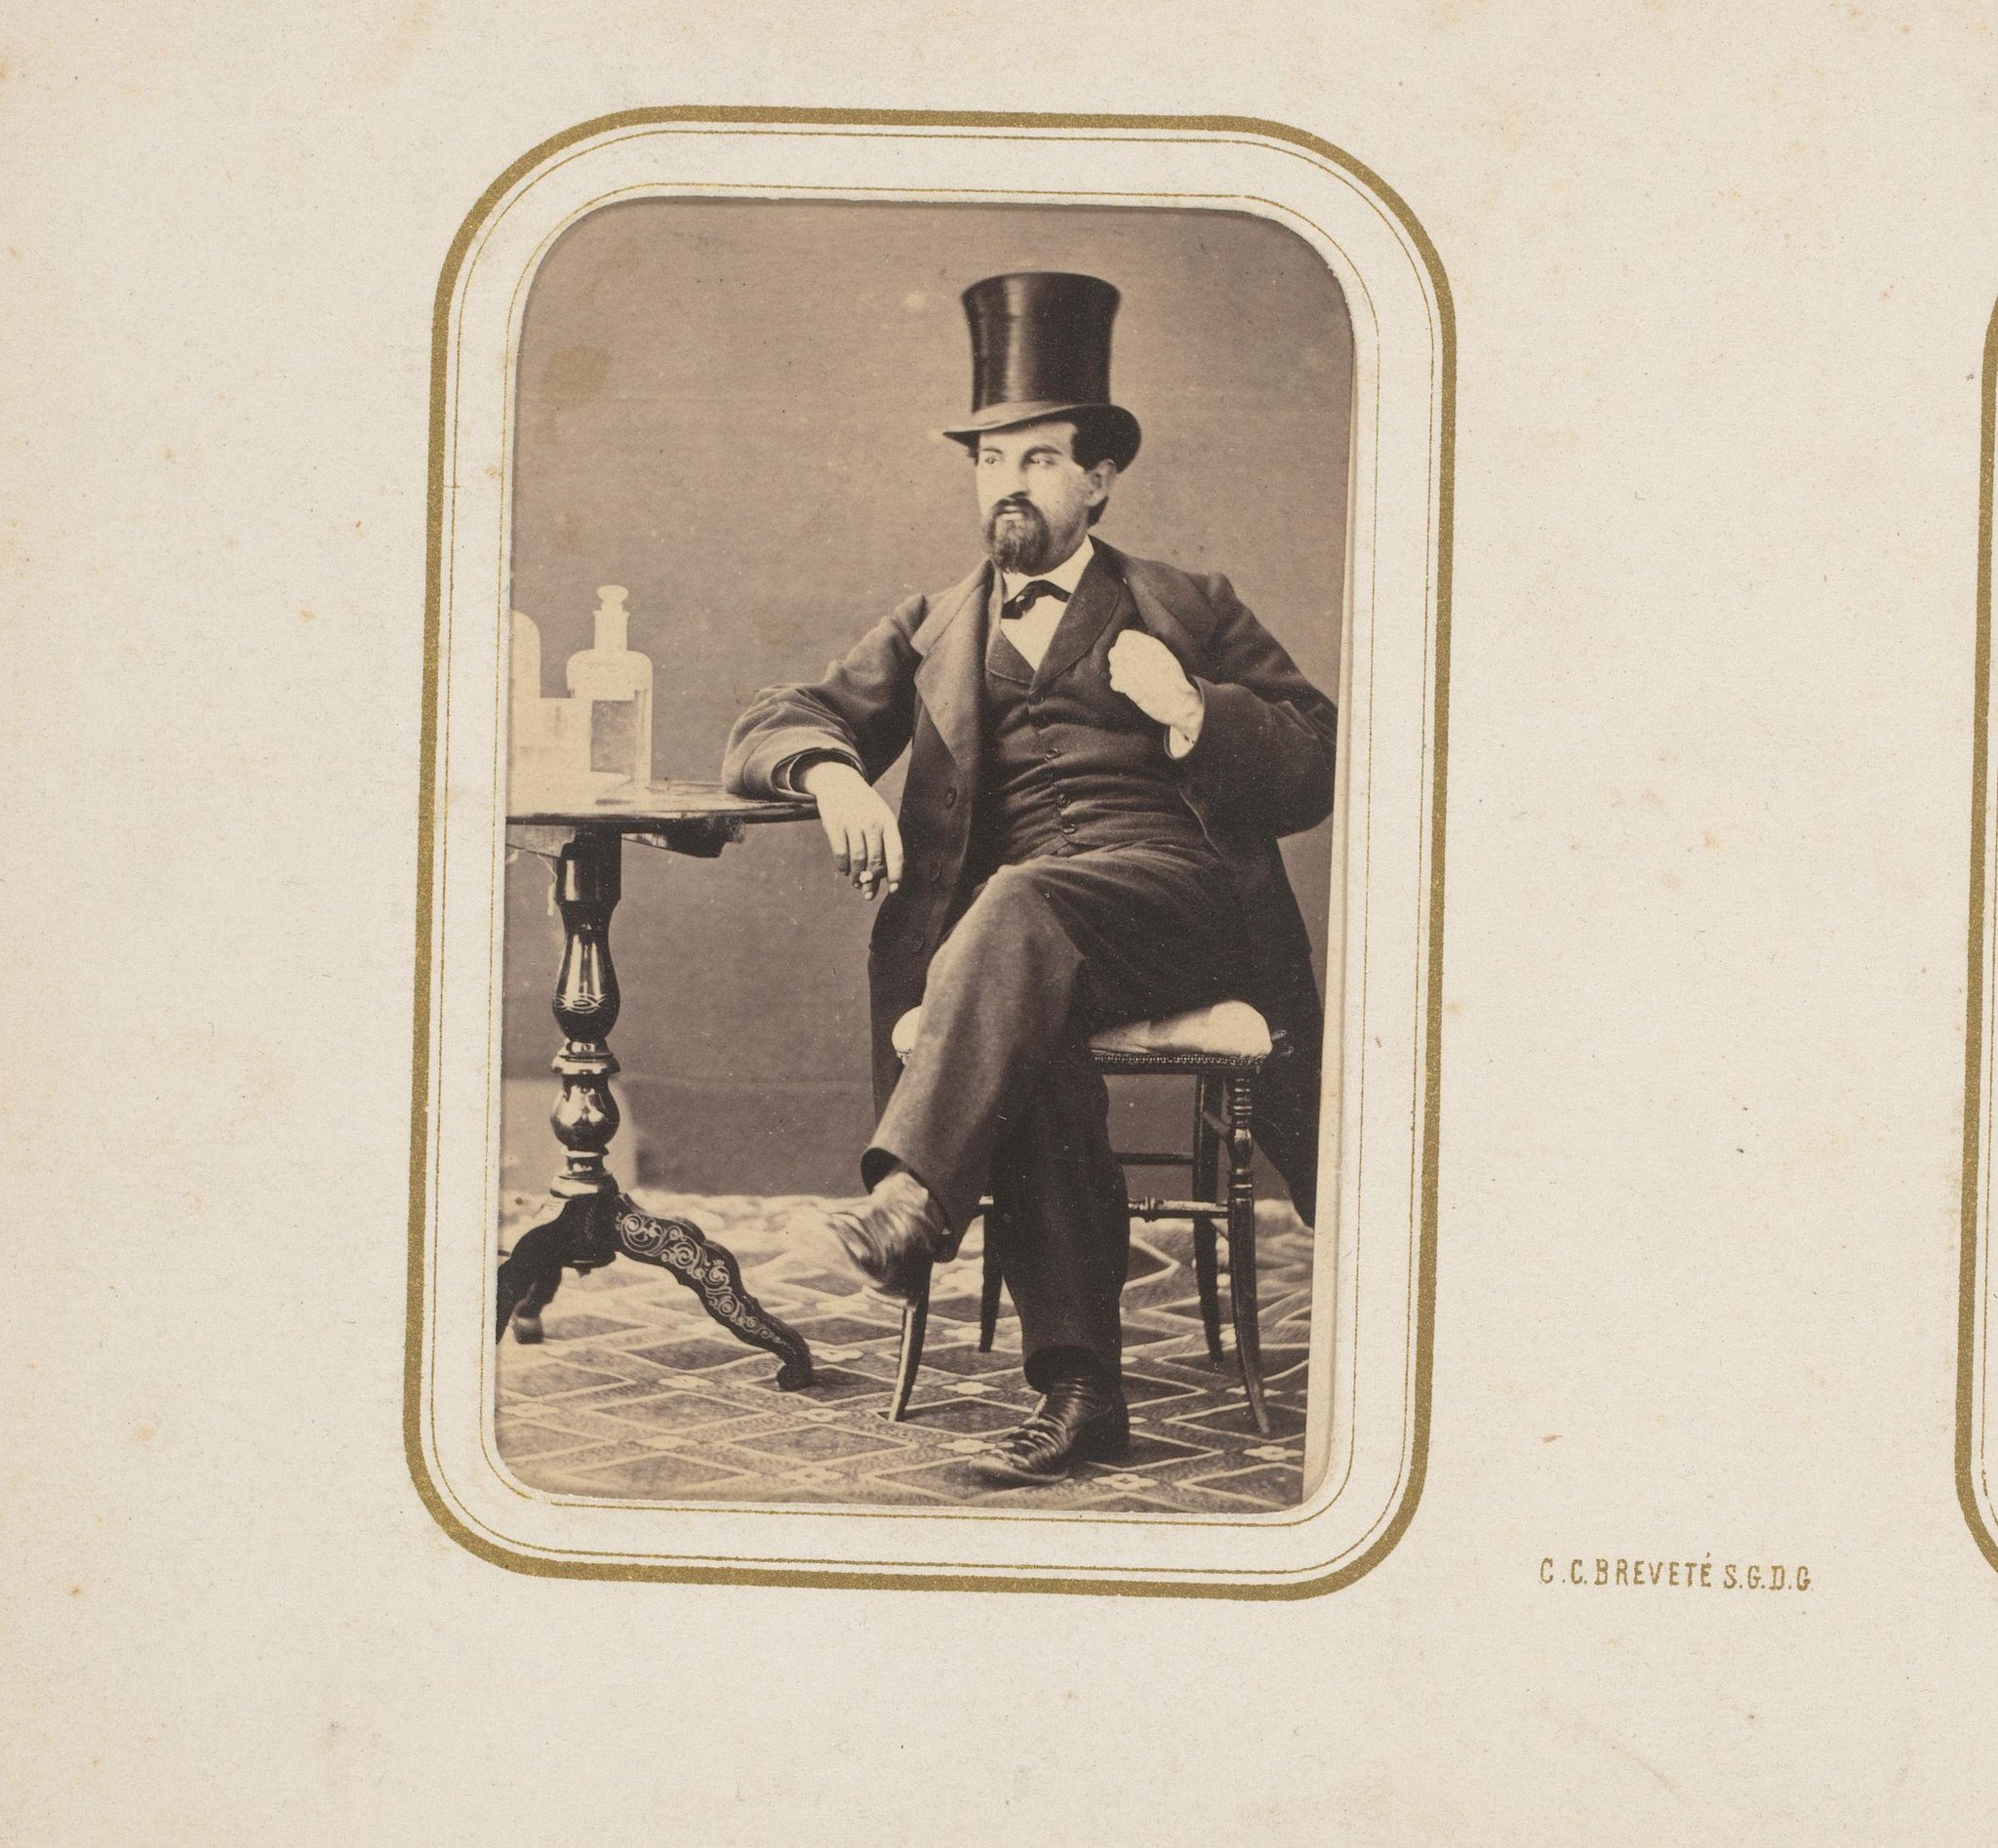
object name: photograph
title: Portret van een man met hoge hoed, zittend aan een tafel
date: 1860-1900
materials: cardboard, photographic support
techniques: albumen print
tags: adult man, historical persons, head-gear: top hat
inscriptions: inscription: ‘Fotografia Española/ Pasaje Colon no. 2/ Barcelona’